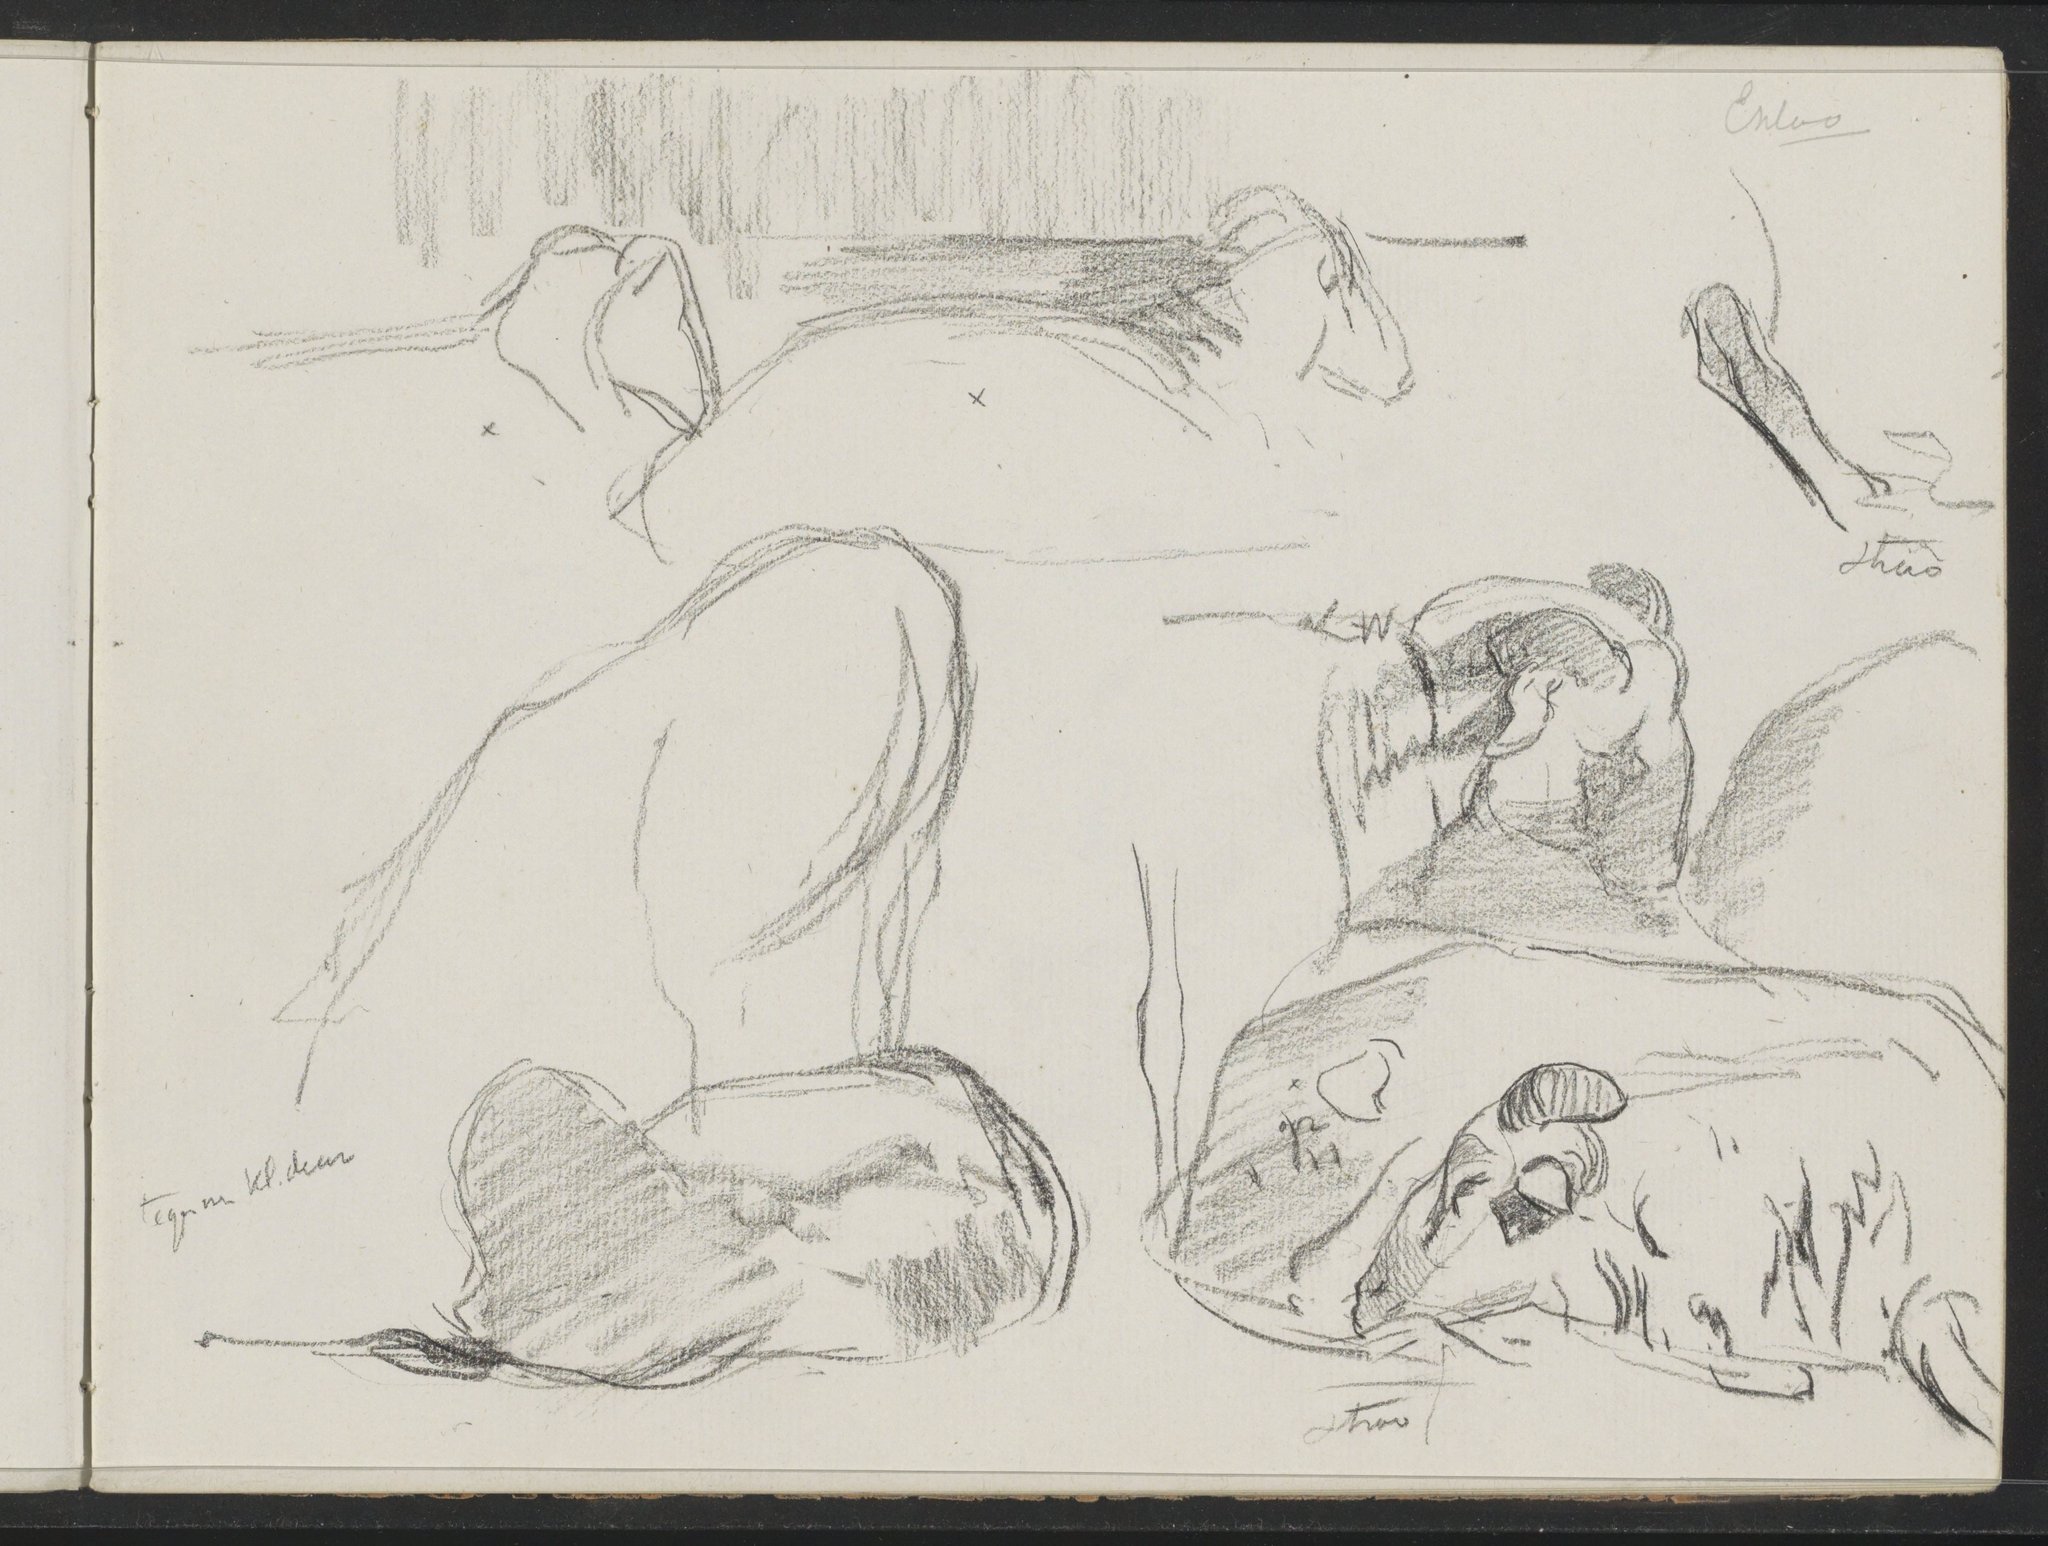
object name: sketchbook leaf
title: Studieblad met schapen te Exloo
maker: ferdinand oldewelt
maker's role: draughtsman, print maker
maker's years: 1857-1935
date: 1904-1912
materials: chalk, paper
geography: exloo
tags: sheep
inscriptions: annotation: ‘tegen[...] kl. deur/ Exloo/ stroo/ stroo’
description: Blad 21 recto uit een schetsboek met 27 bladen.